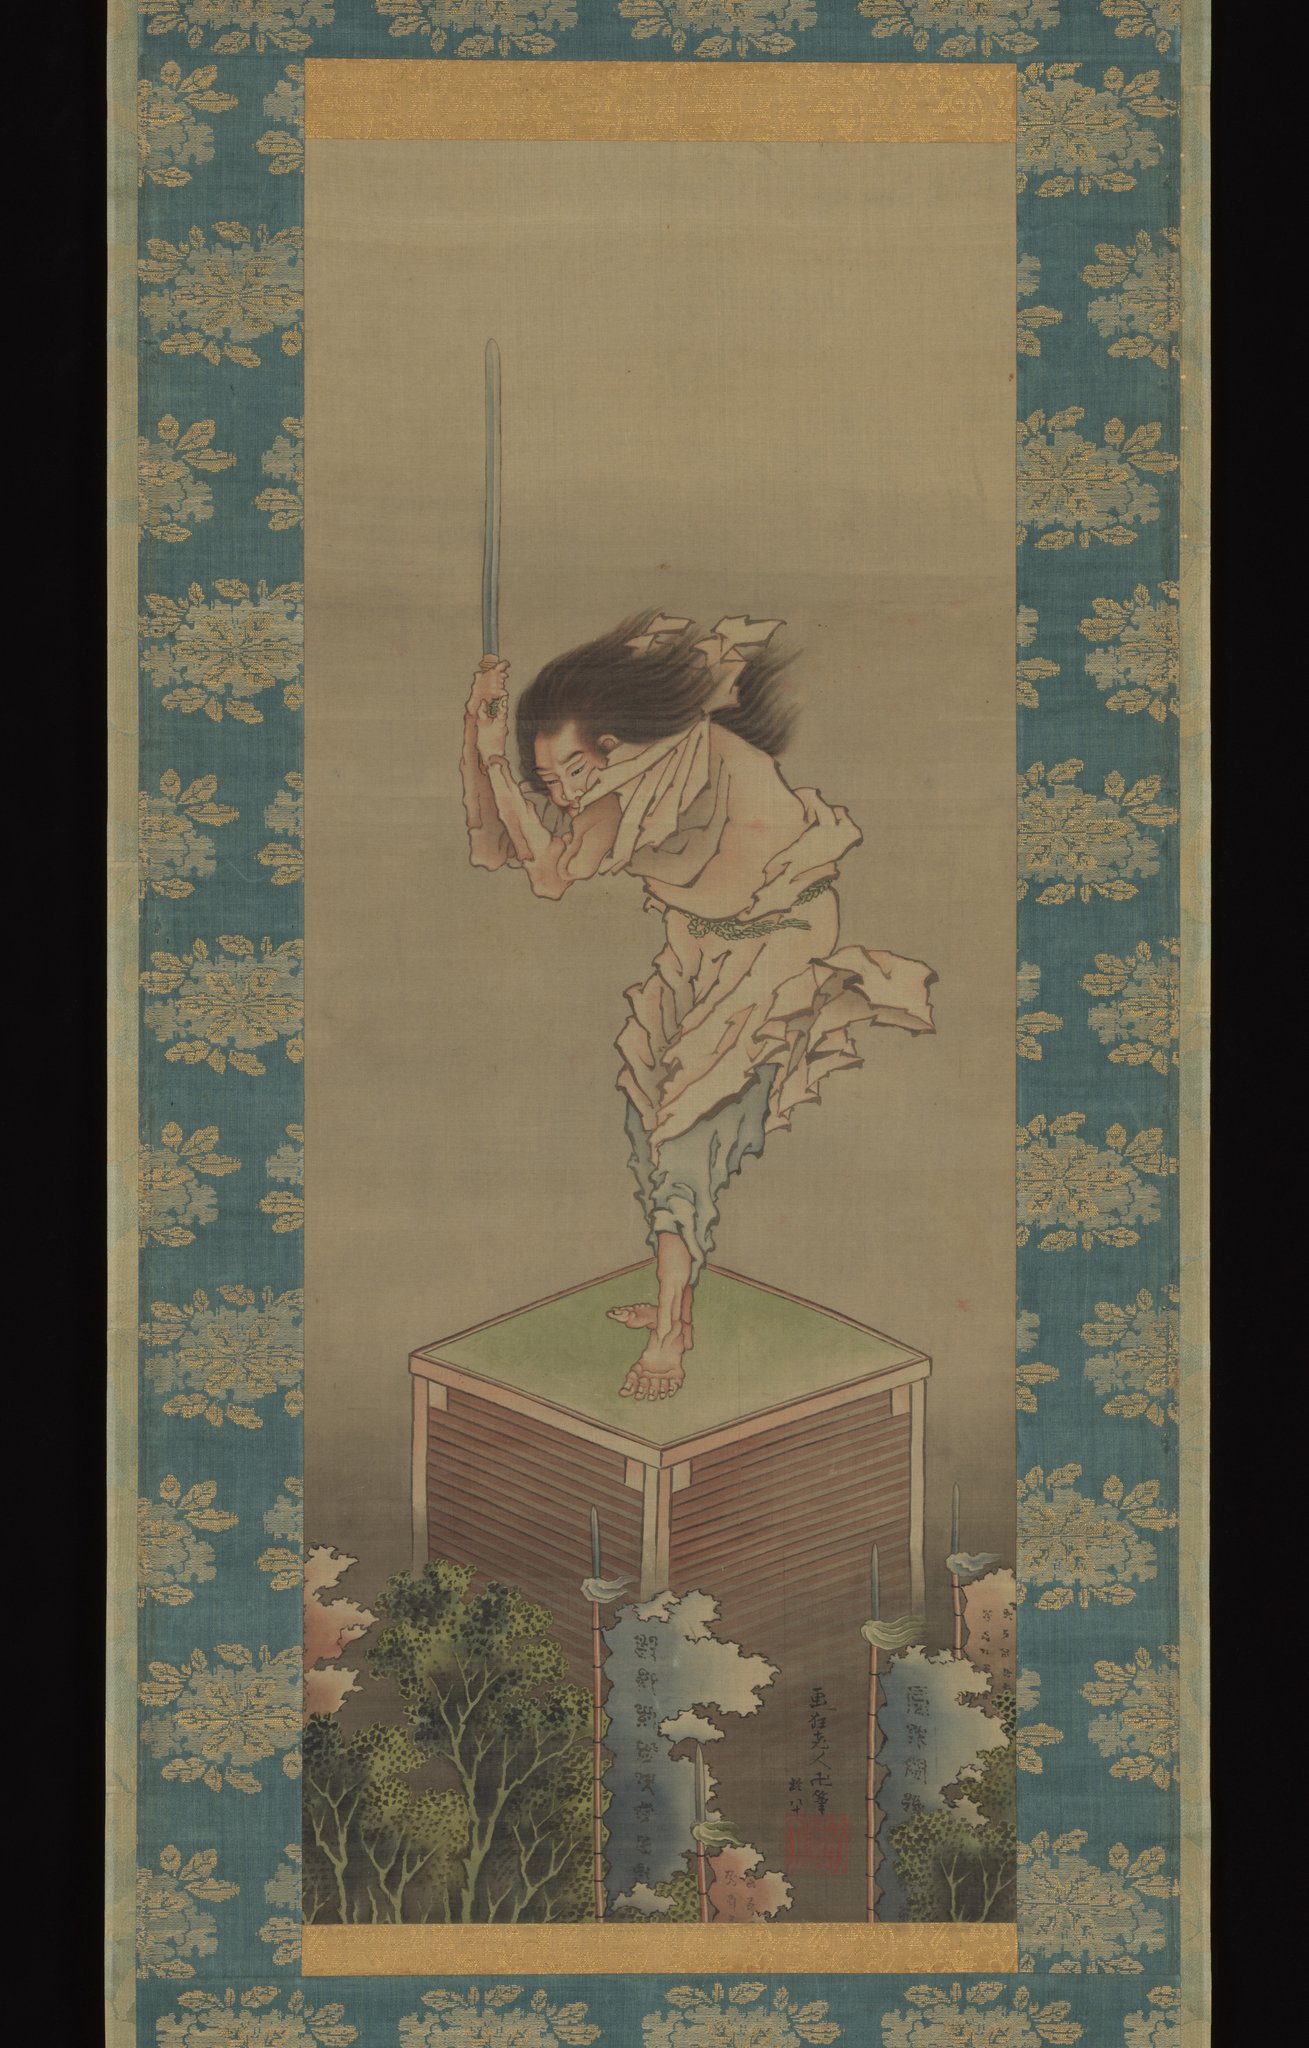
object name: hanging scroll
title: Sword Dancer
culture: japanese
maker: katsushika hokusai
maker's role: artist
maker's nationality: japanese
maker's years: 1760-1849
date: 1801-1900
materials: ink, silk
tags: swords,dancers